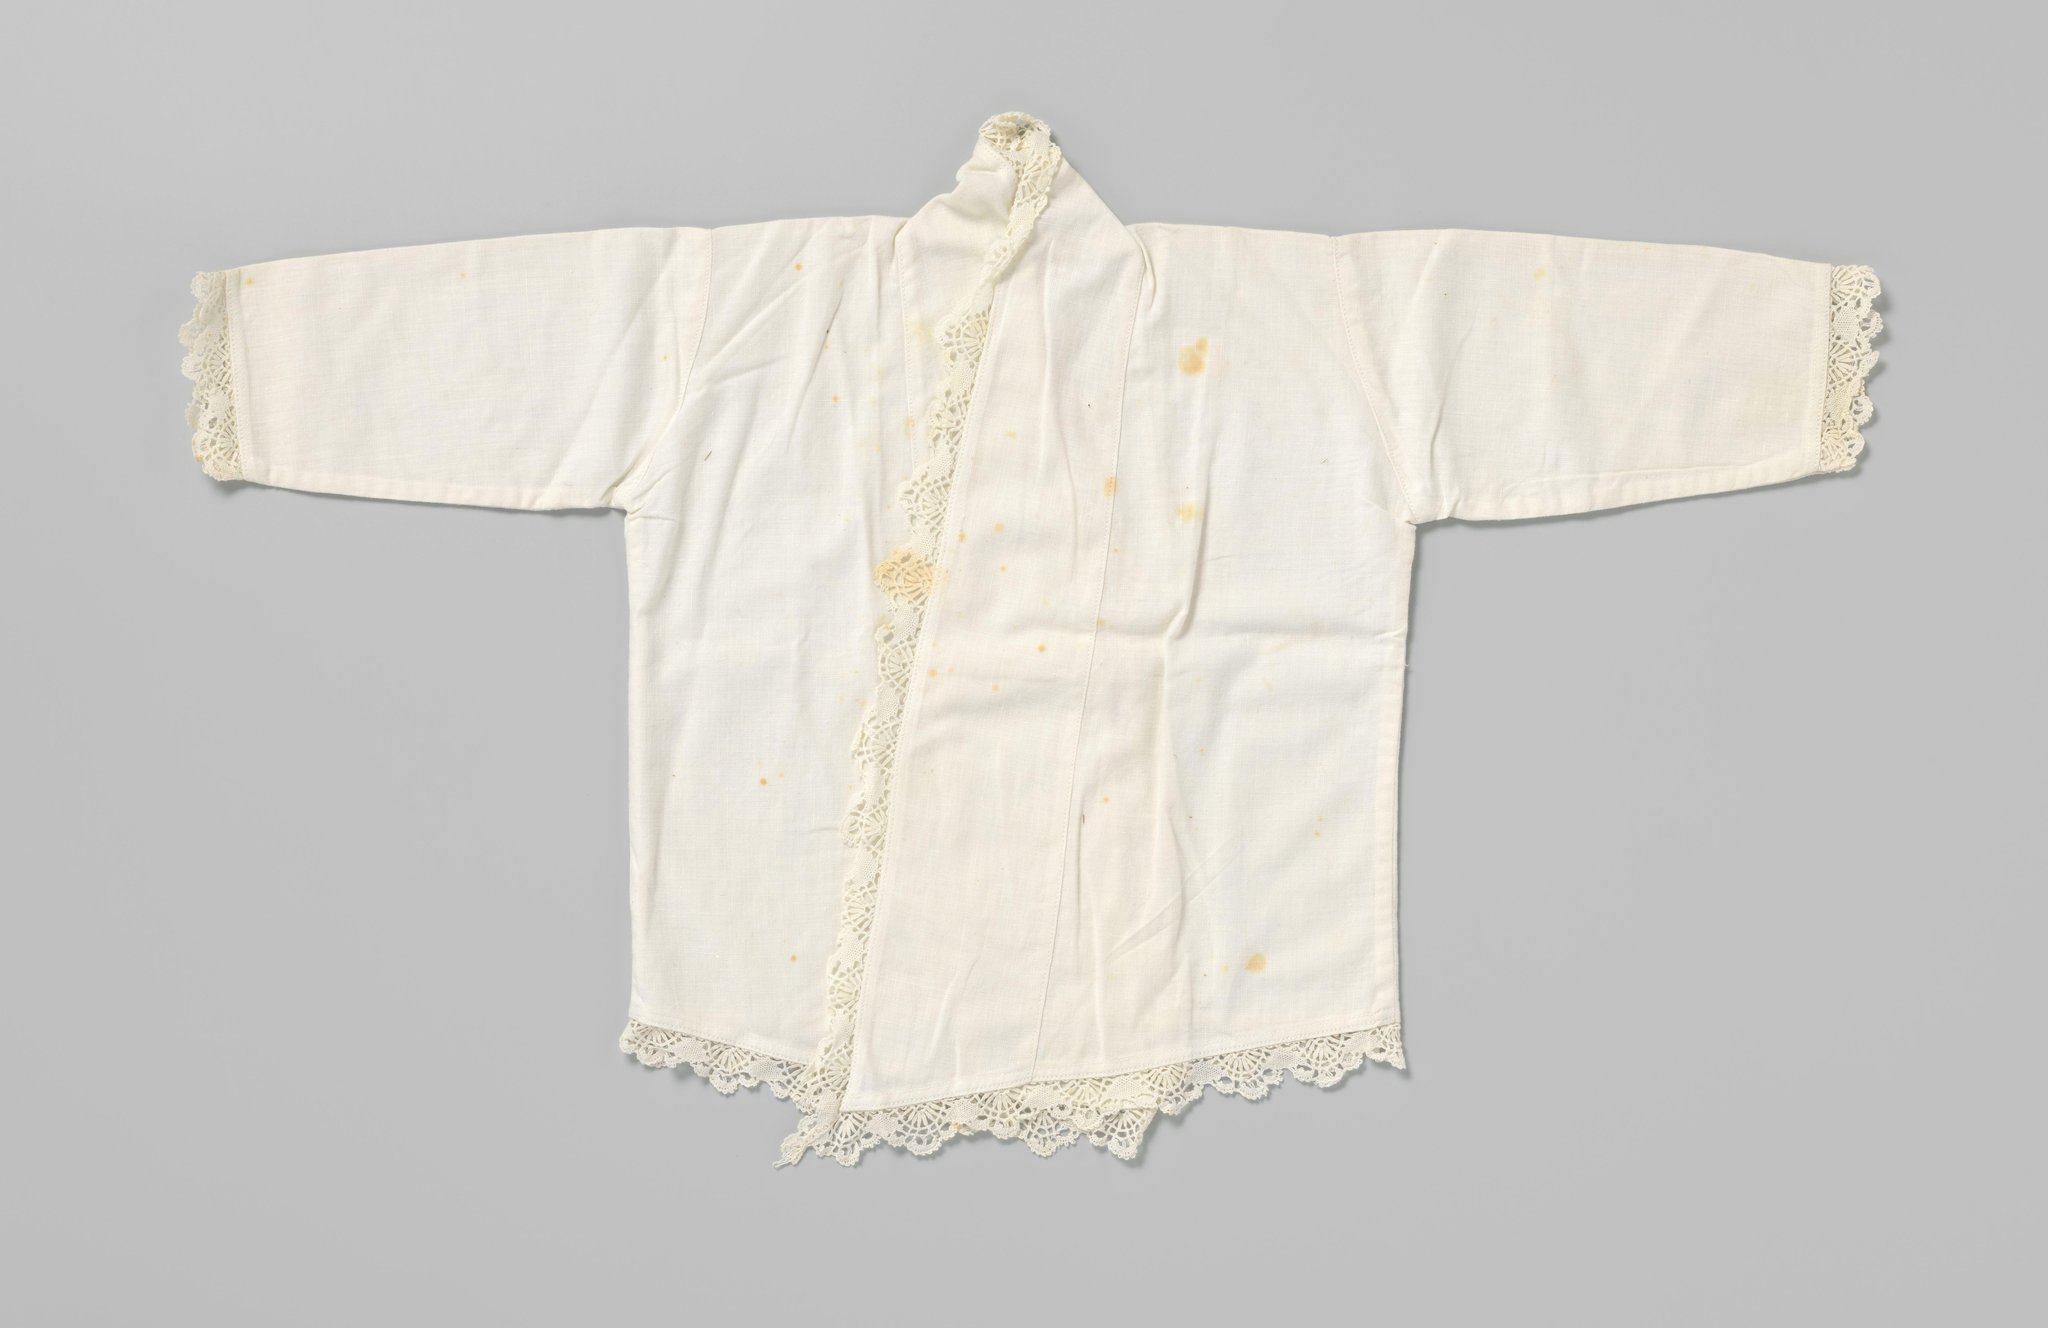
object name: kabaja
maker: Anonymous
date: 1904-1908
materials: cotton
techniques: needle lace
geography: malang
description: Kabaja van witte katoen afgezet met naaldkant.